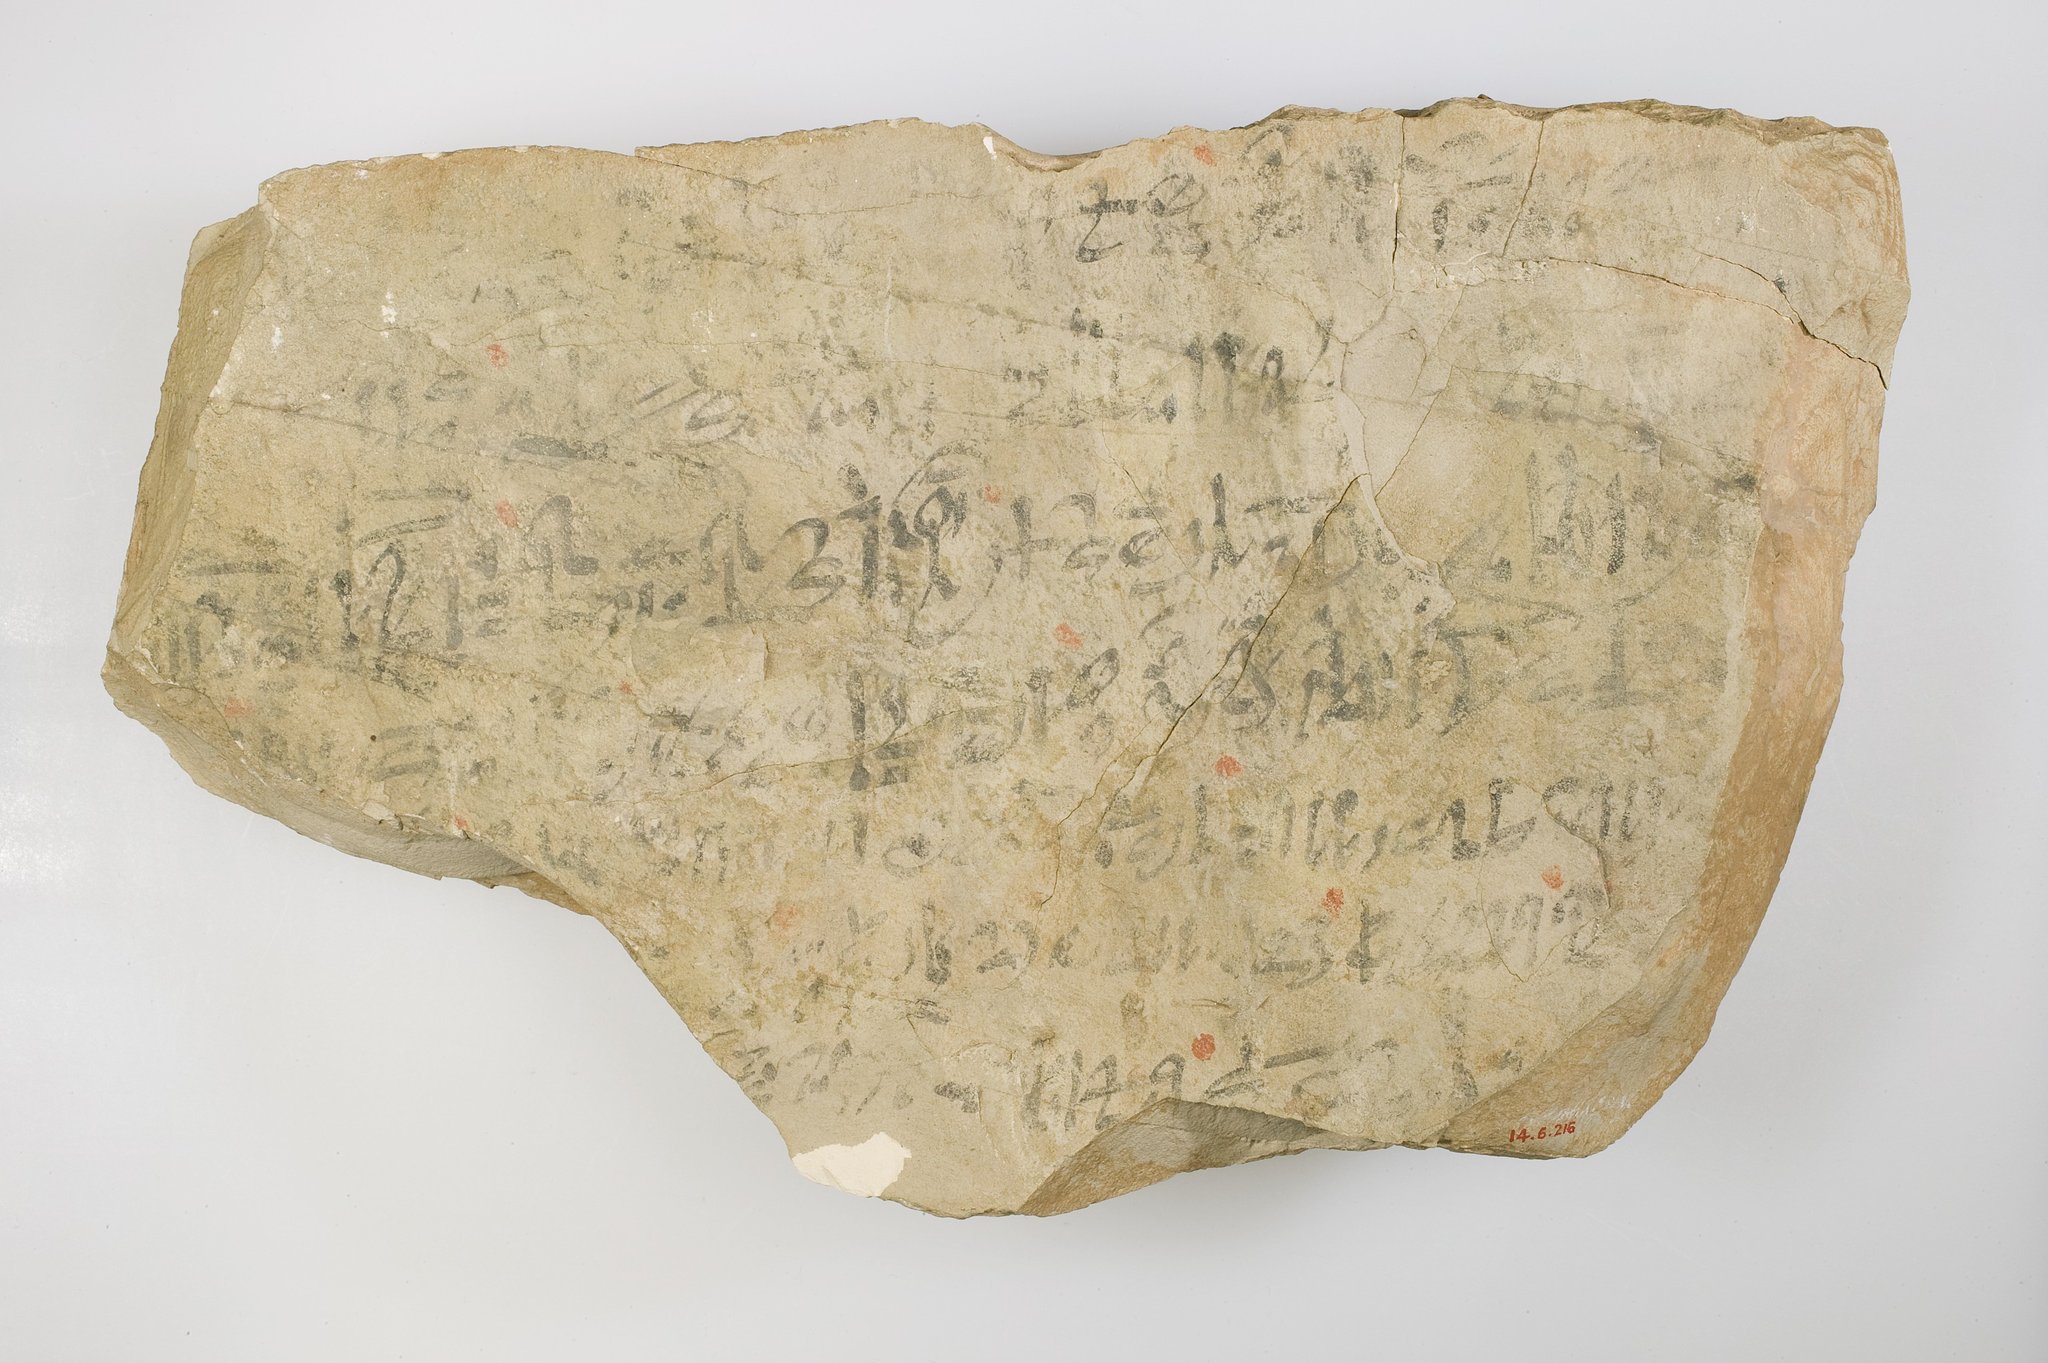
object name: ostracon, hieratic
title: Hieratic ostracon inscribed with literary text and work journal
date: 1295-1070 BCE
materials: ink, limestone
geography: egypt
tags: hieratic